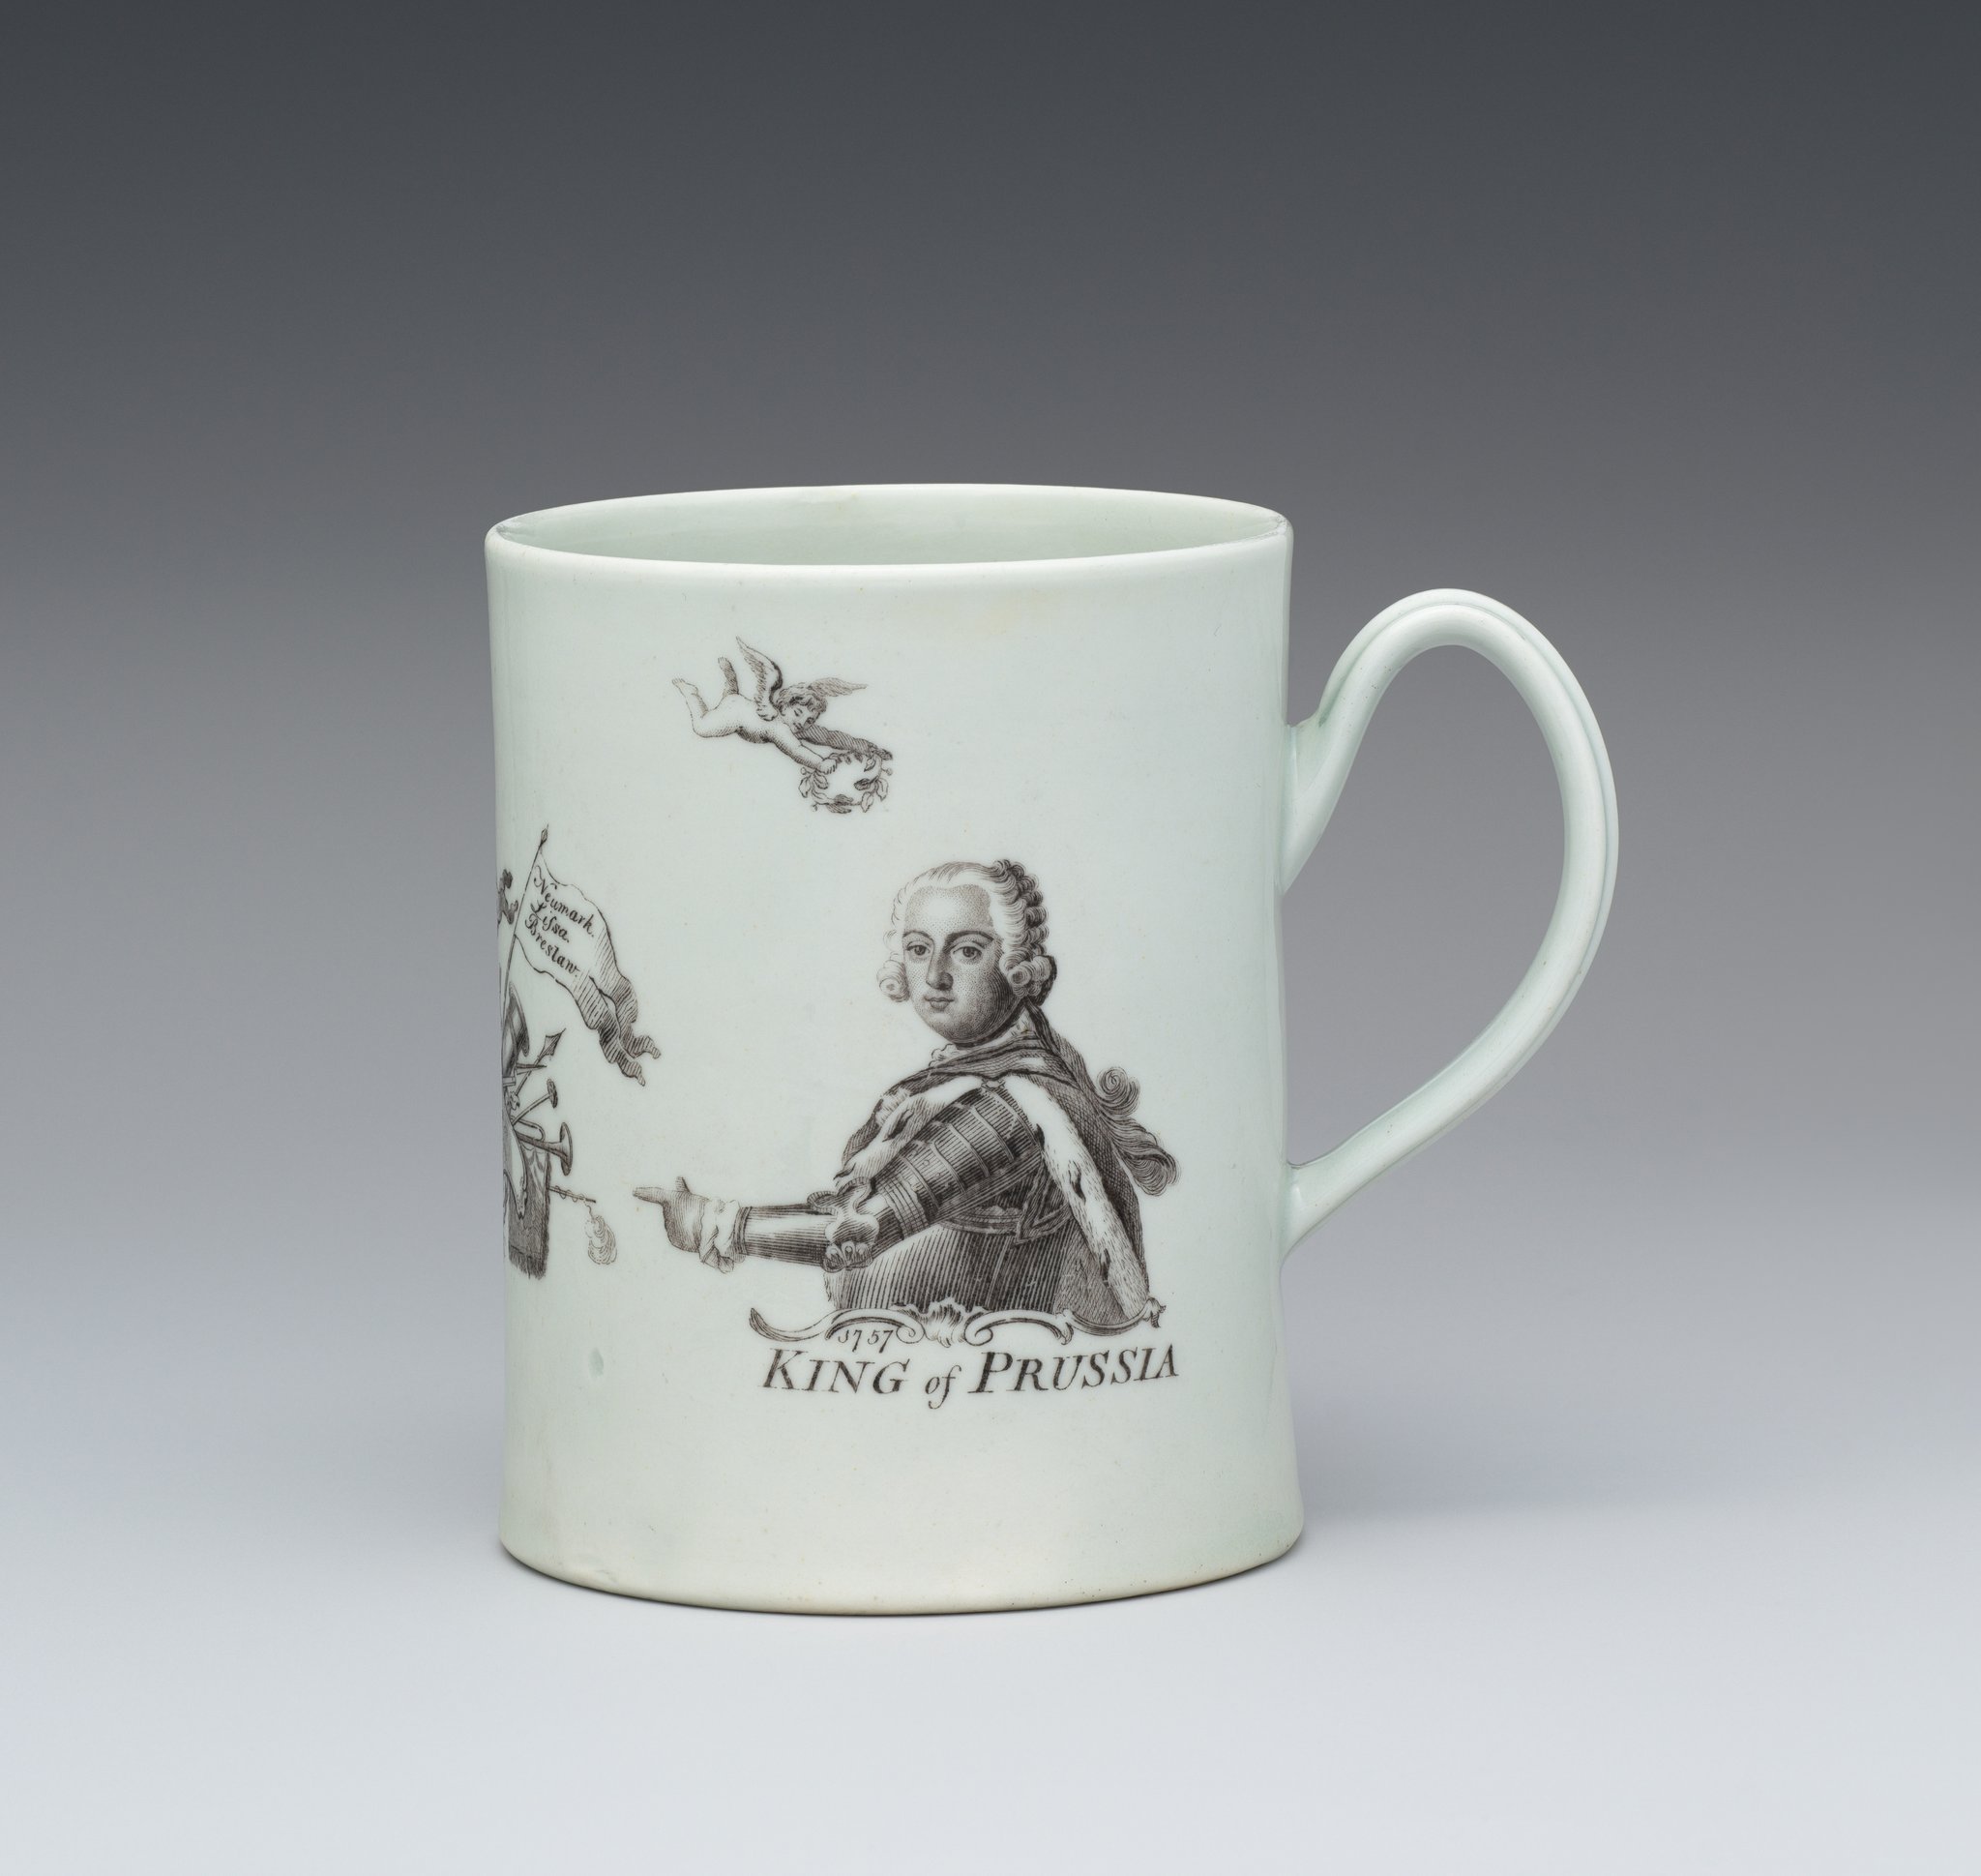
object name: mug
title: Mug with portrait of Frederick the Great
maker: worcester factory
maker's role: factory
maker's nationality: british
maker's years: 1751-2008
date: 1757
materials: soft paste porcelain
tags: kings,portraits